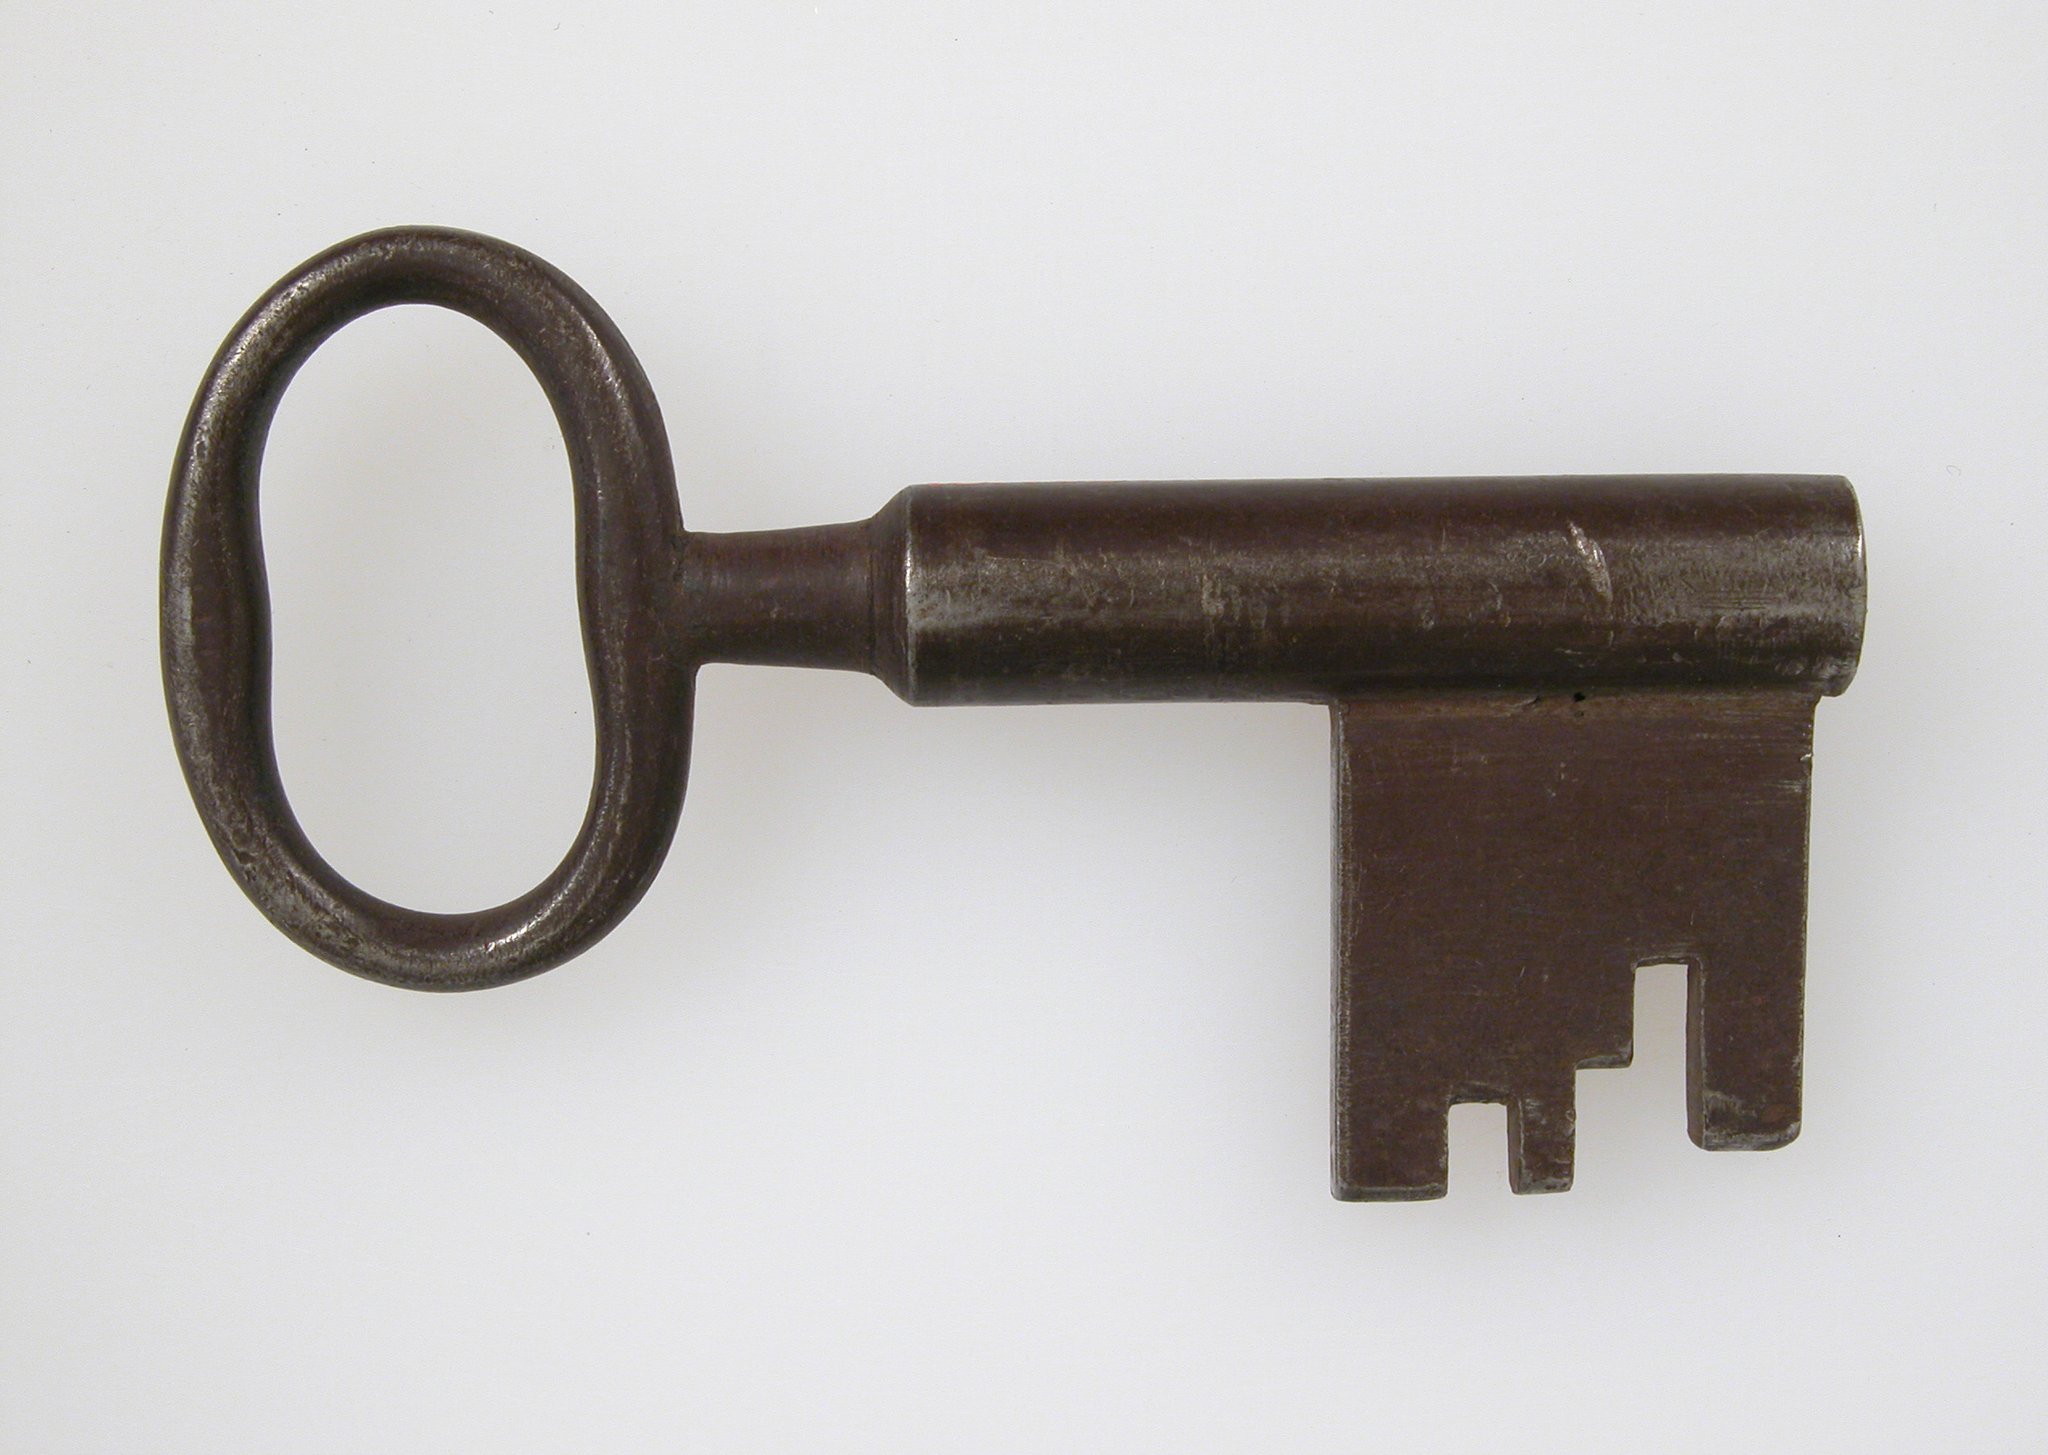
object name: key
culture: german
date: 1401-1500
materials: iron